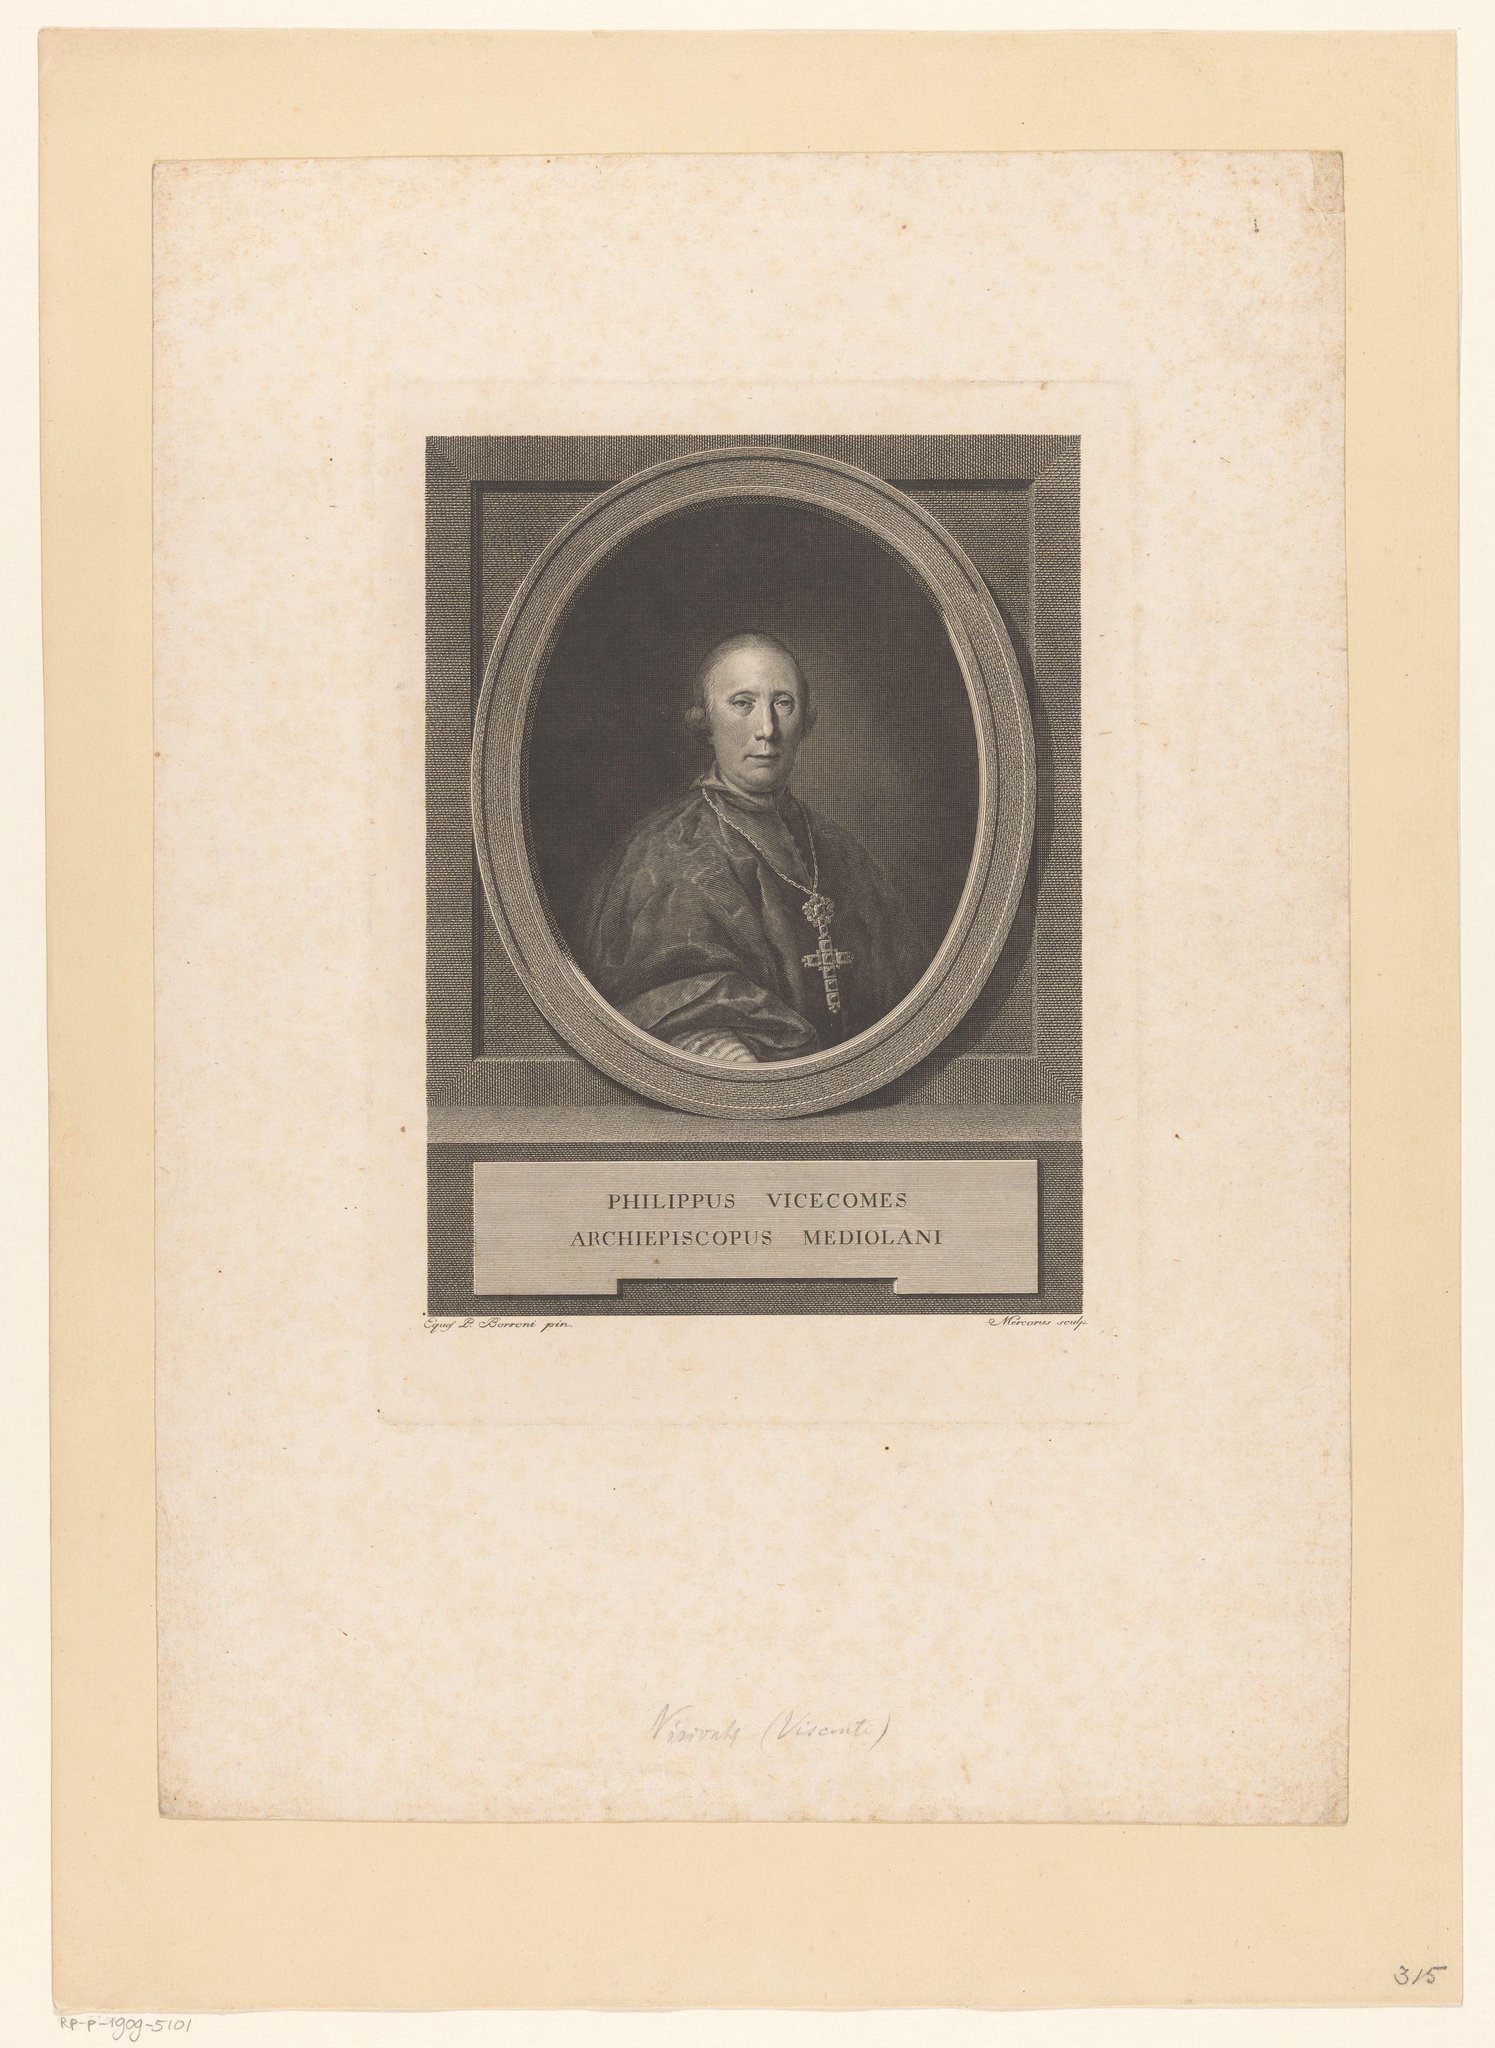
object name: print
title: Portret van Filippo Maria Visconti, aartsbisschop van Milaan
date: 1784-1799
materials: paper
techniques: engraving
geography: italy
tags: archbishop, bishop, etc. (roman catholic), historical persons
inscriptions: collector's mark: Lugt 2228